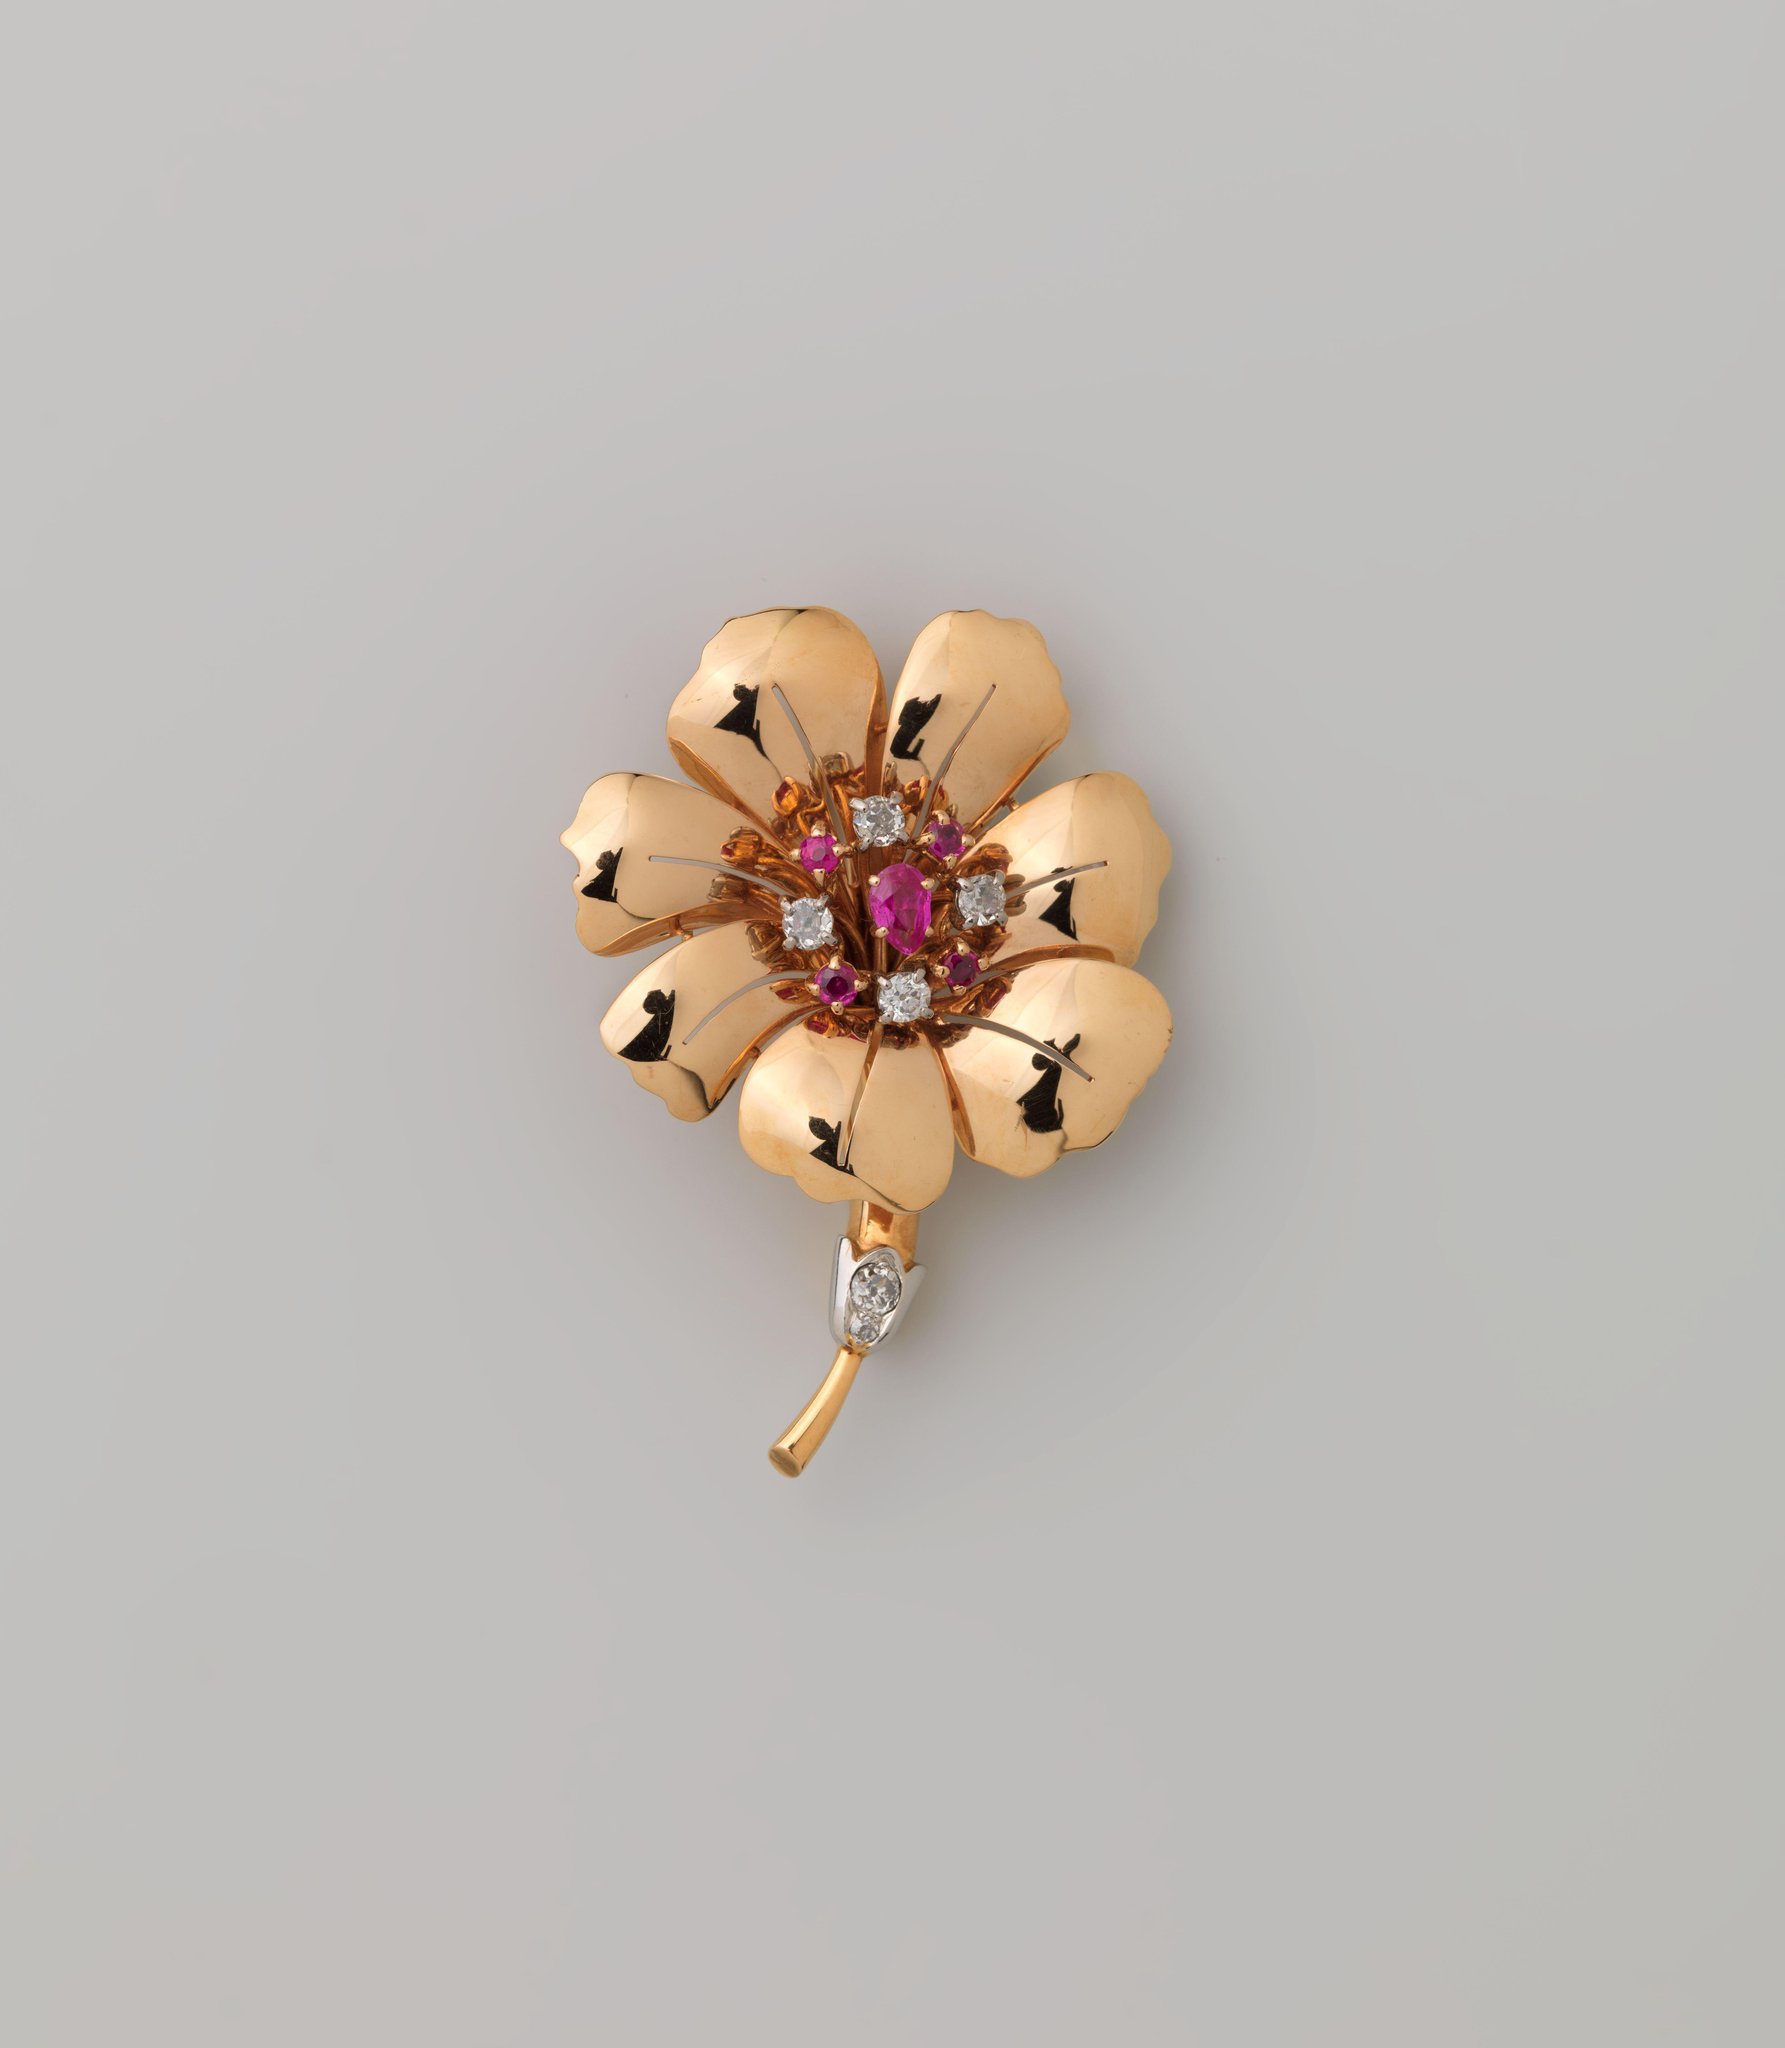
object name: brooch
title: Broche van goud met robijn en diamanten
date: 1945-1953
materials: diamond, gold, gemstone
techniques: grinding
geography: the hague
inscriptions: maker's mark: ‘V.Z.K.’, alloy mark: ‘leeuw, zogenaamde kies’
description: Broche van goud in de vorm van een bloem met centraal een rozet met daarin een pendaloque geslepen robijn in entourage van vier rond gefacetteerde robijnen en drie gefacetteerde diamanten, voorzien van een kanonsluiting. In de steel in witgoud gezet twee gefacetteerde diamanten.